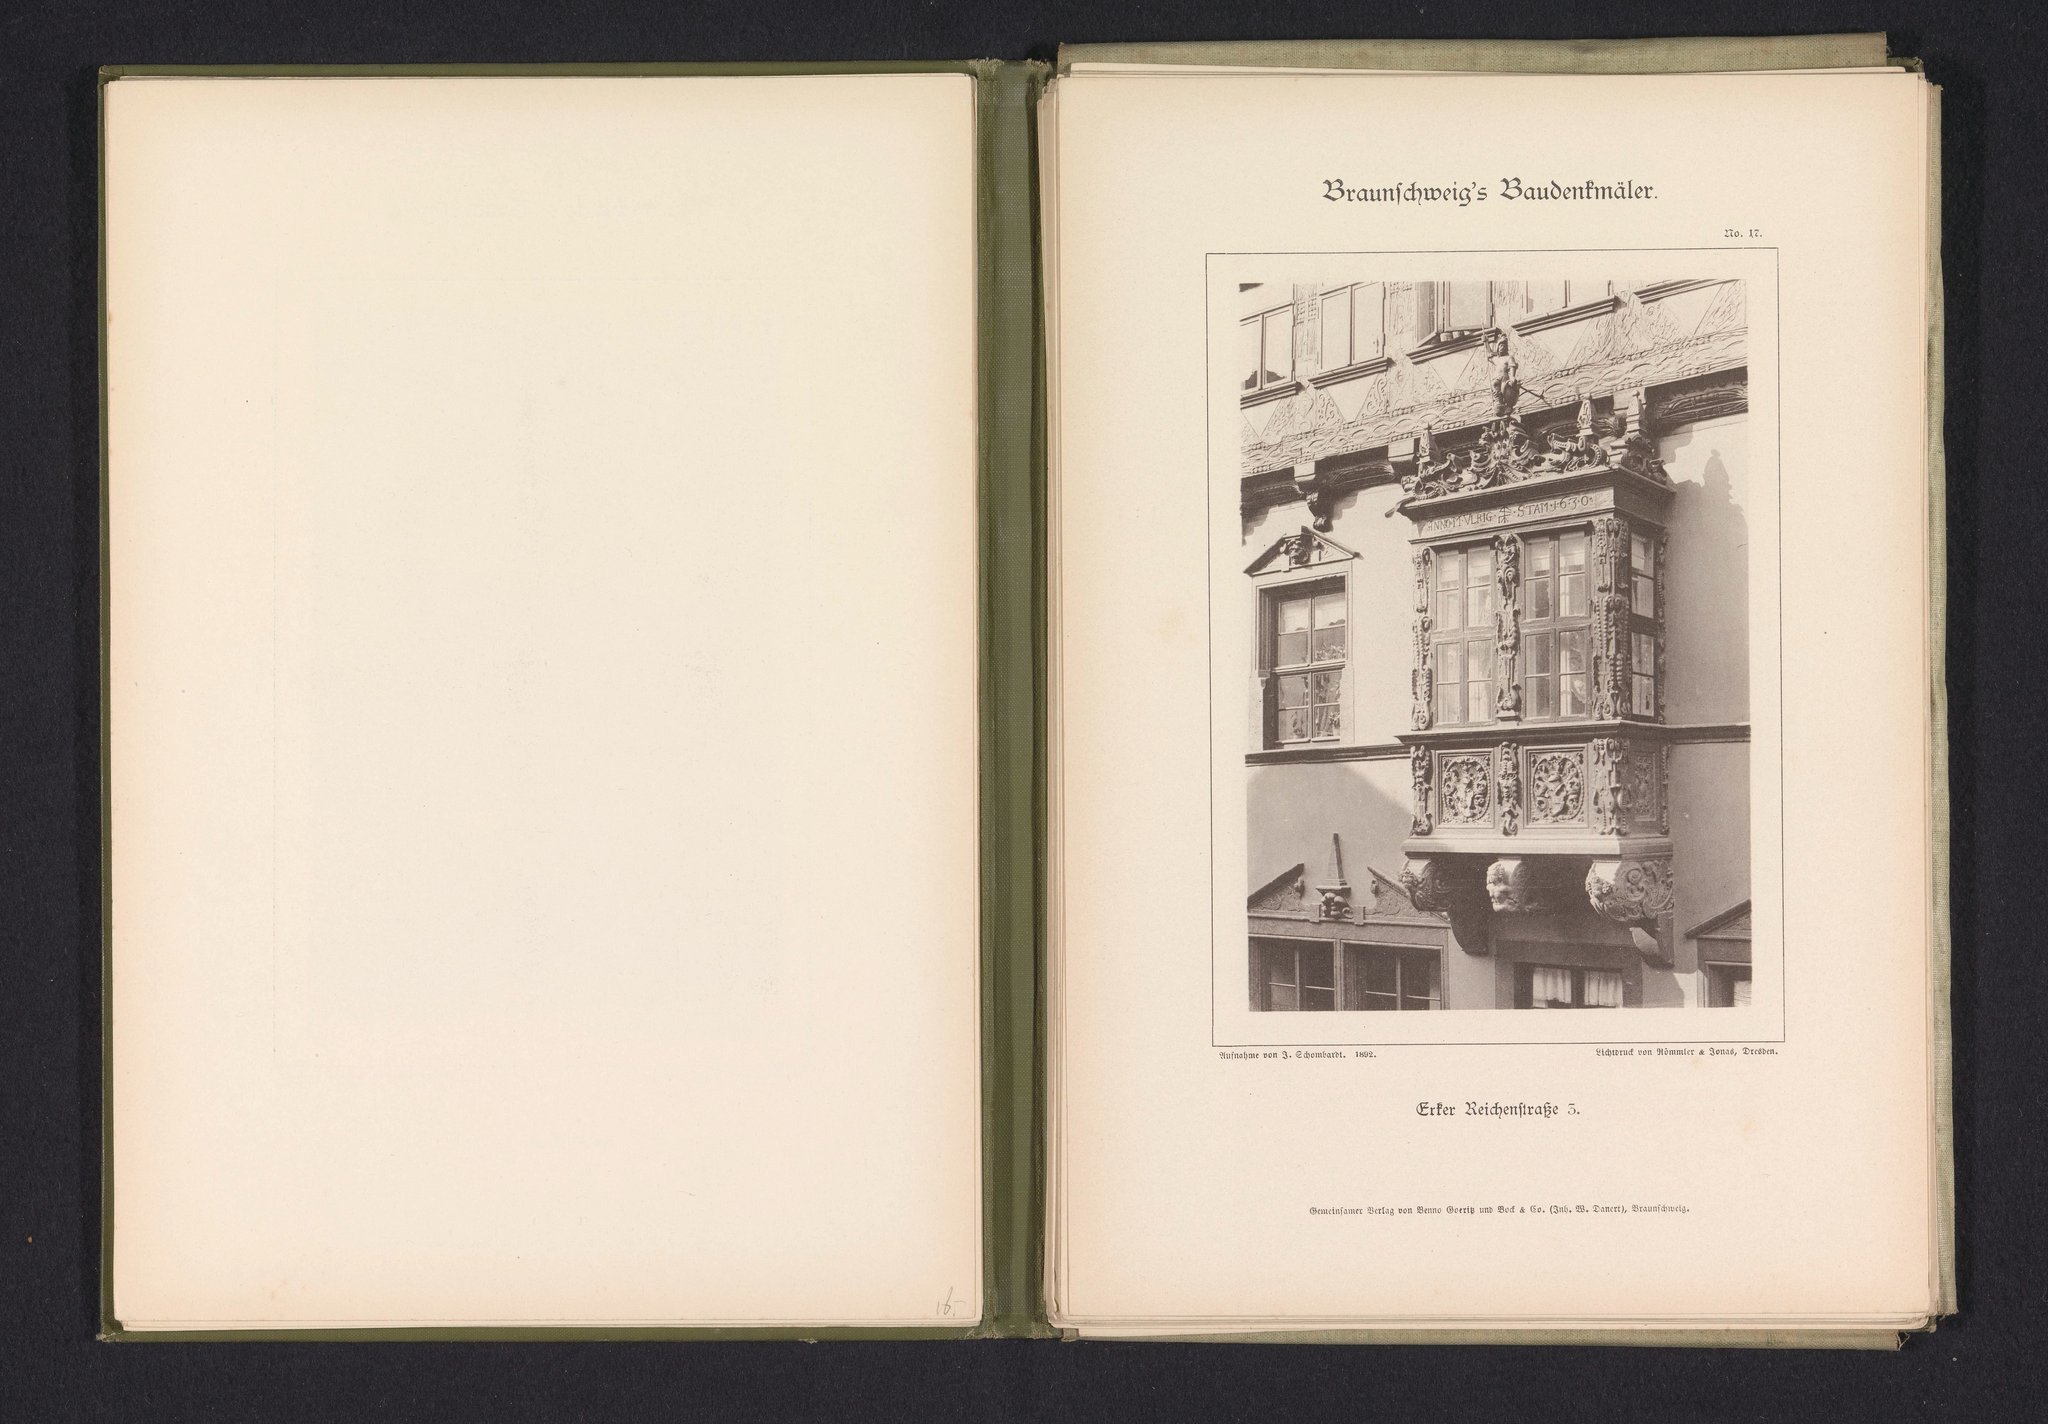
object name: photomechanical print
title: Braunschweig's Baudenkmäler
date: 1892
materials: paper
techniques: photograph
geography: braunschweig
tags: bay-window, oriel, façade (of house or building)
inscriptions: number: ‘No. 17.’